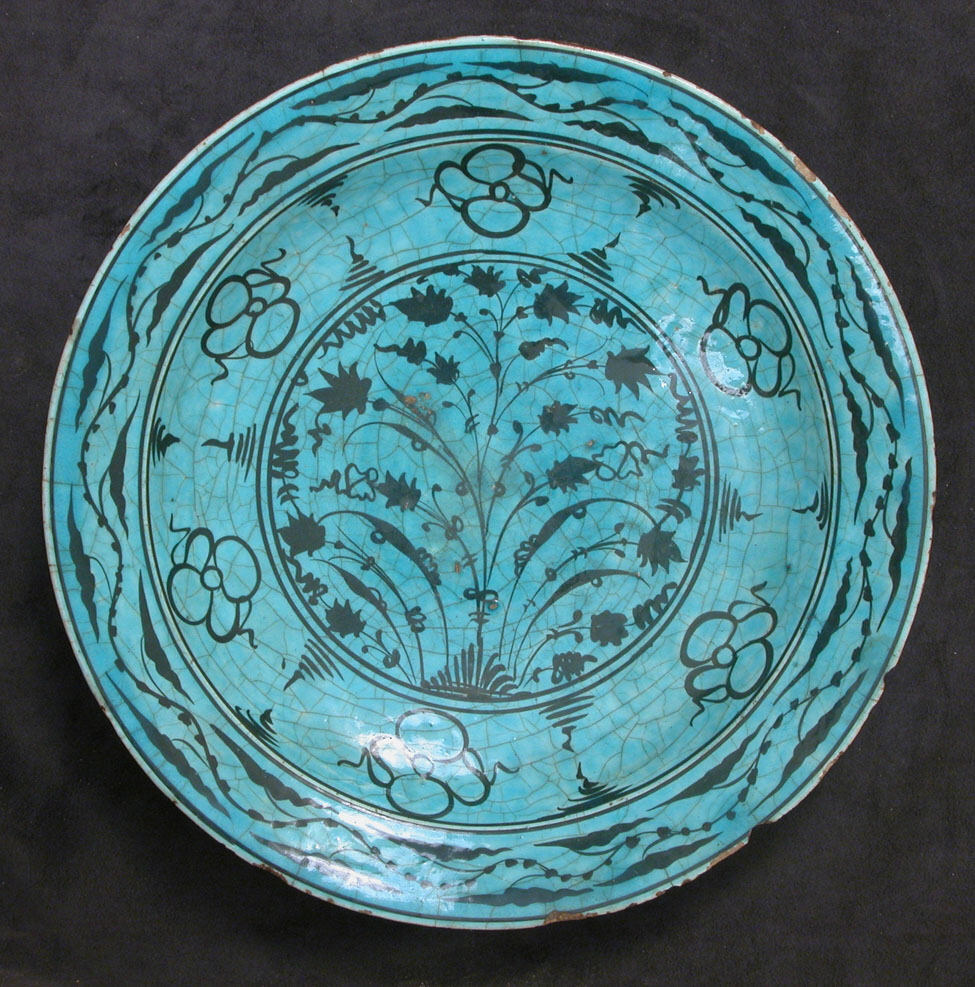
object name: dish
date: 1501-1700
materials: glaze, stonepaste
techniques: painting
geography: iran